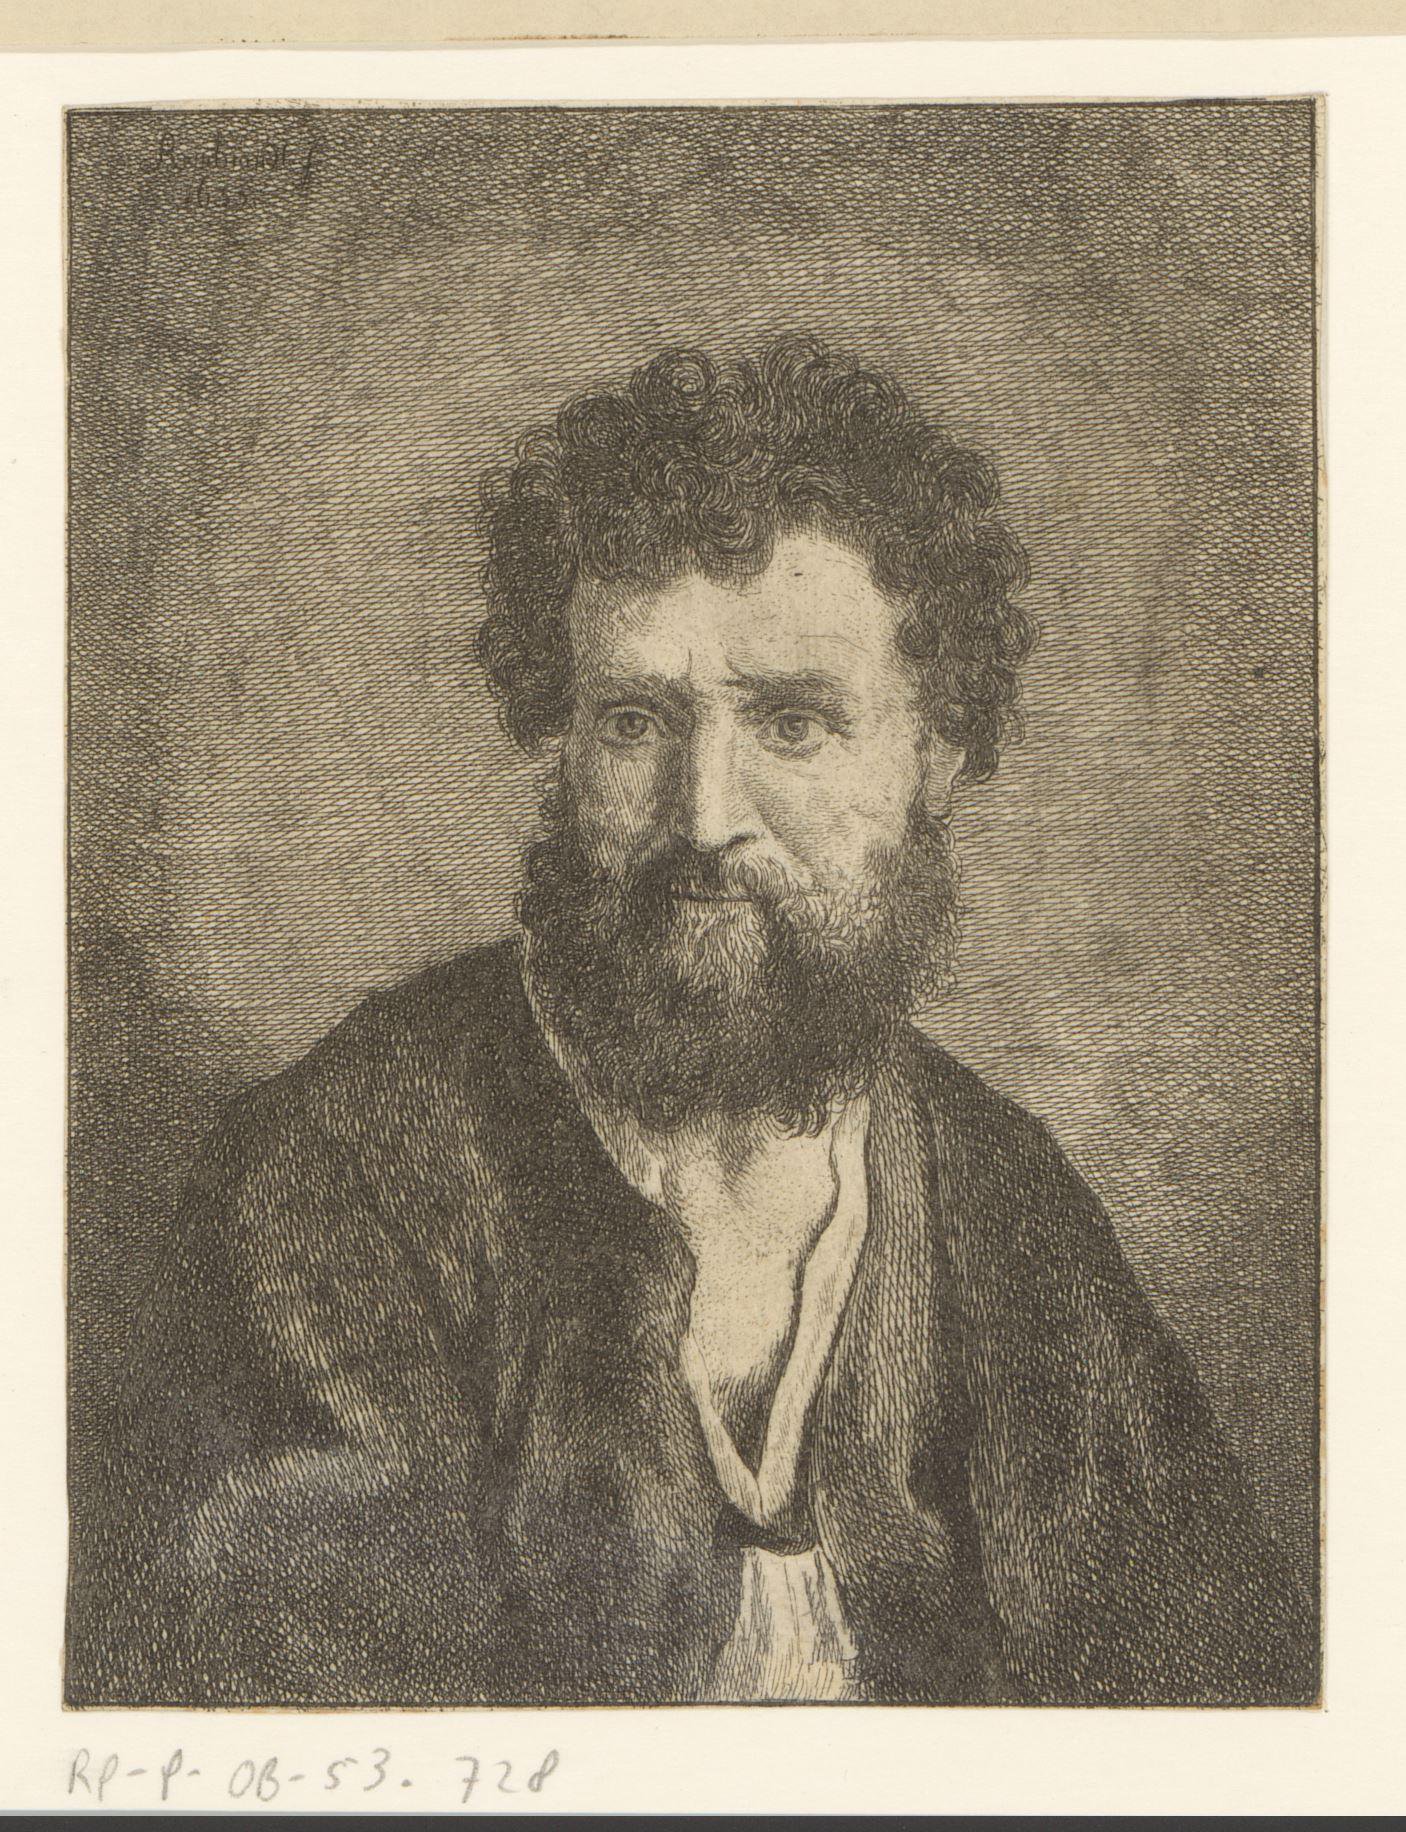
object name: print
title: Portret van een onbekende man met krullend haar en een volle baard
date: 1746-1816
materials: paper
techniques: etching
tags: adult man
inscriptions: collector's mark: Lugt 240